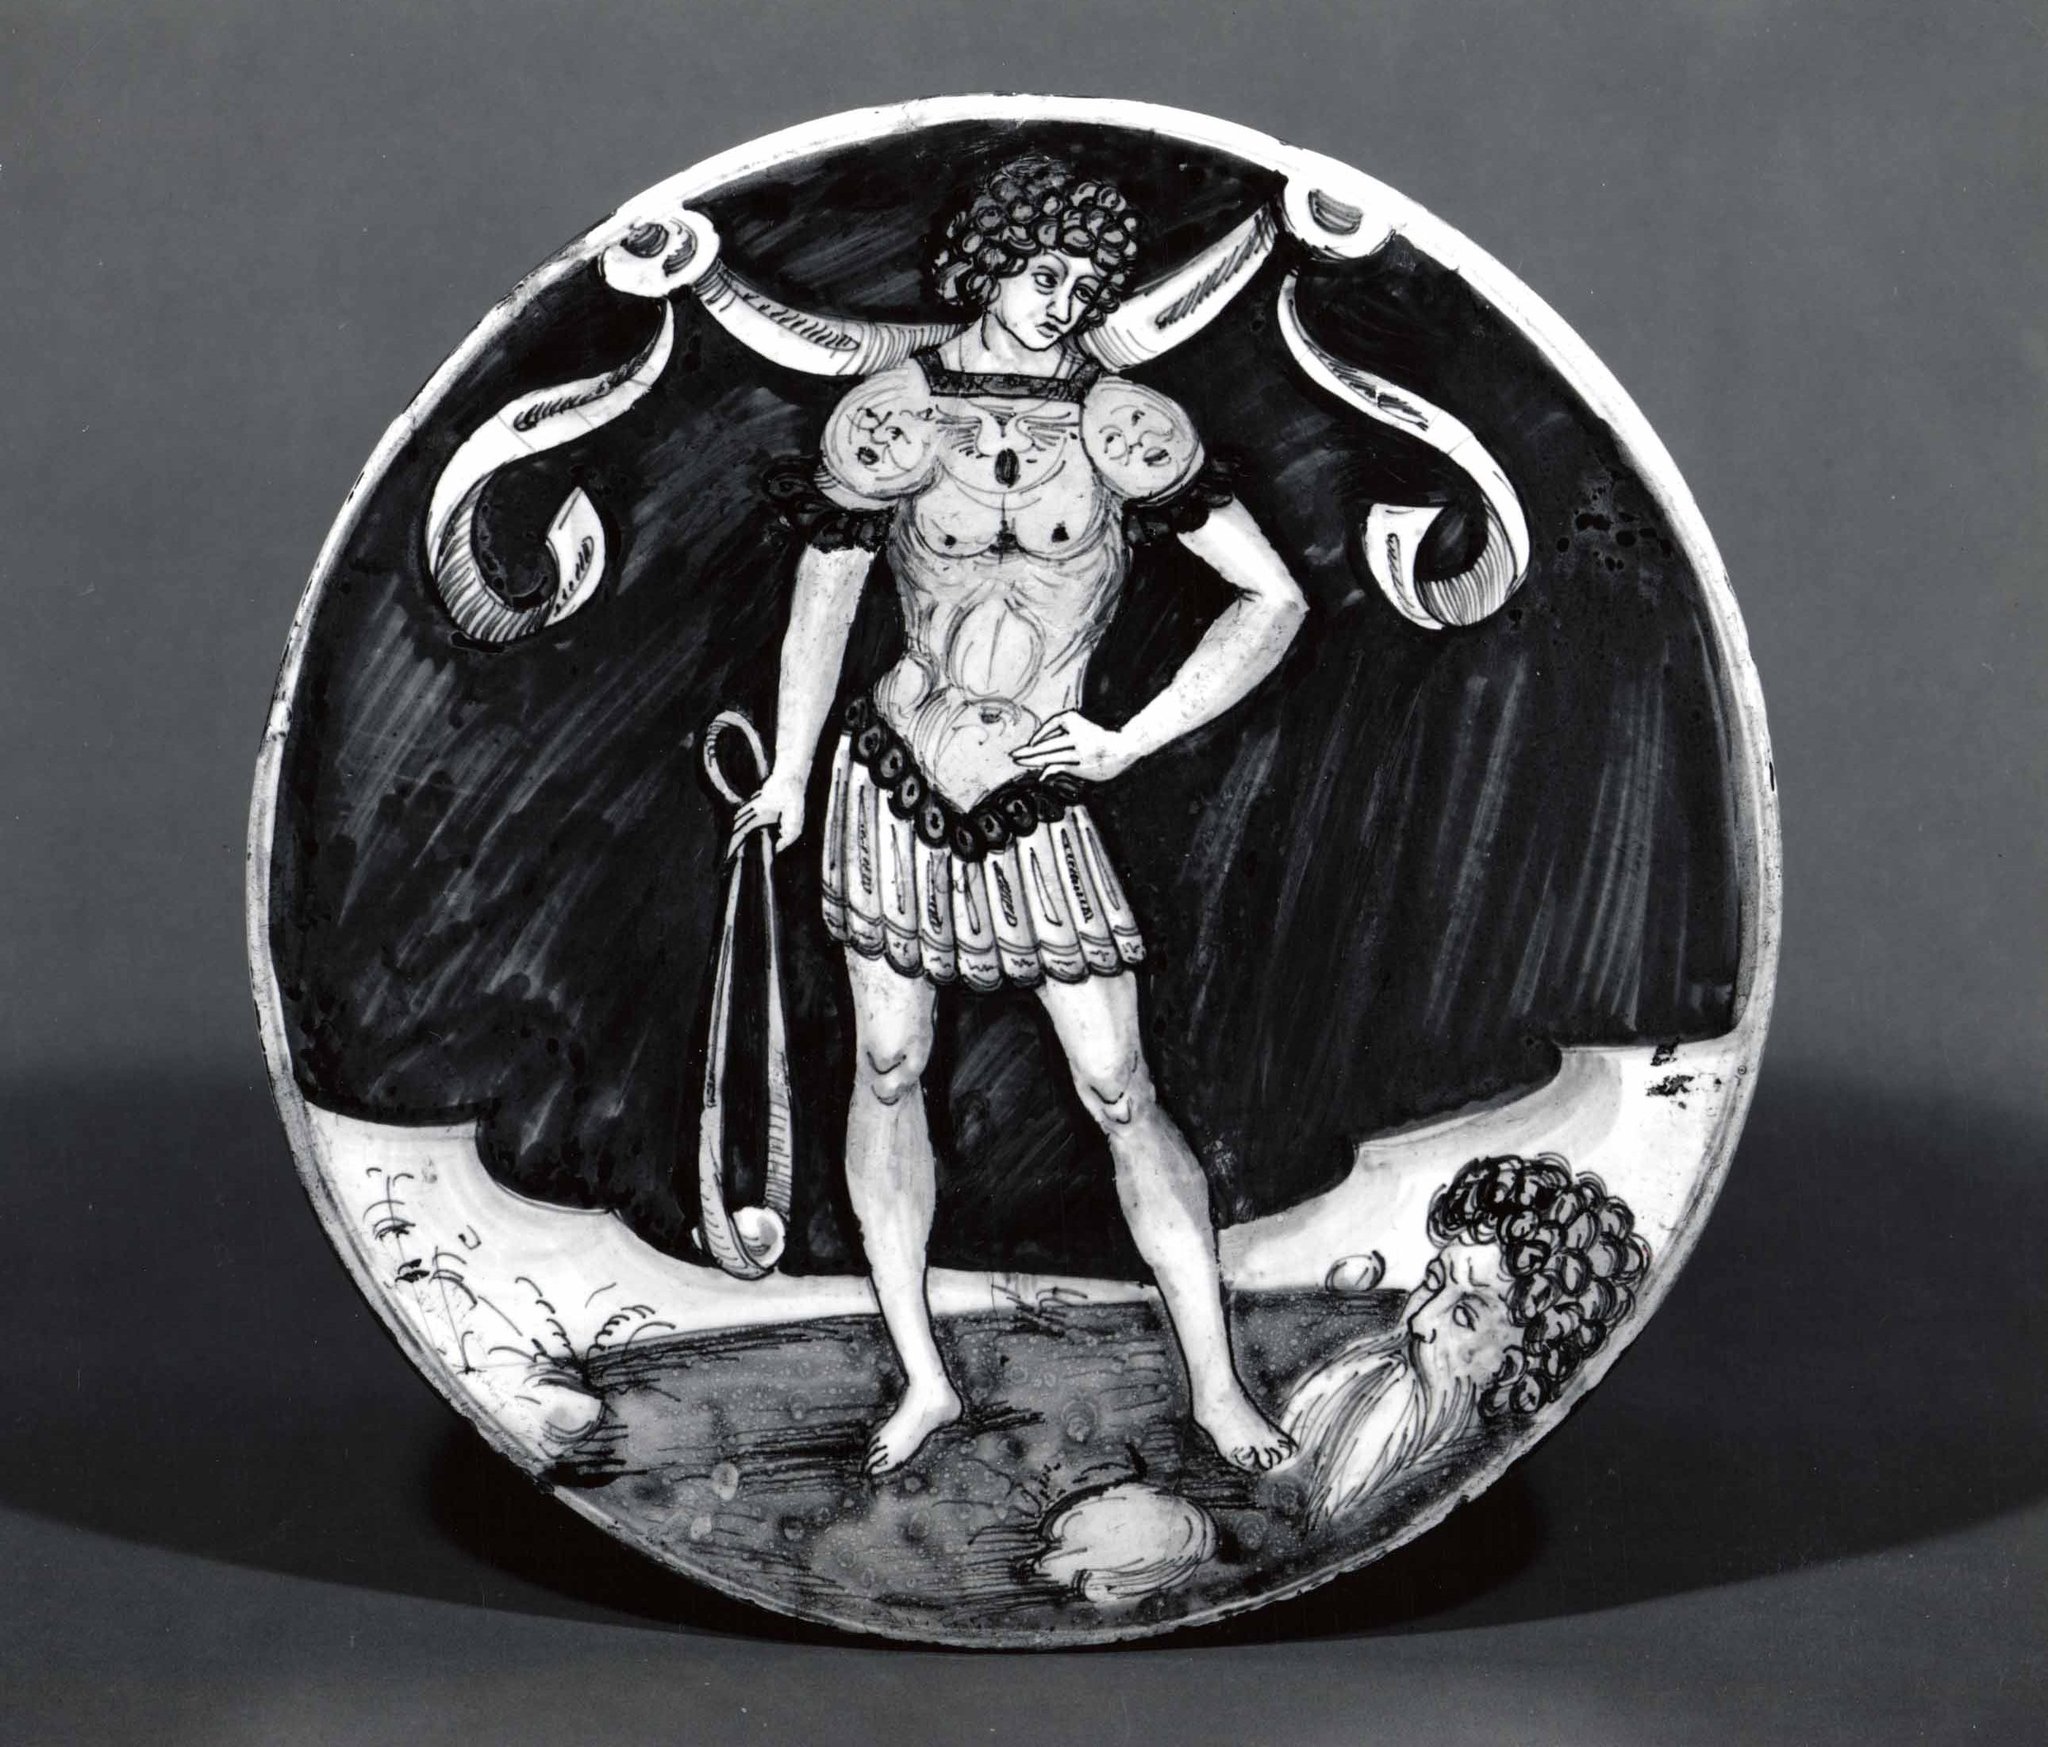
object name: dish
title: Dish (coppa)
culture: italian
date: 1520-1530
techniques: maiolica, glazing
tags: men,david,goliath